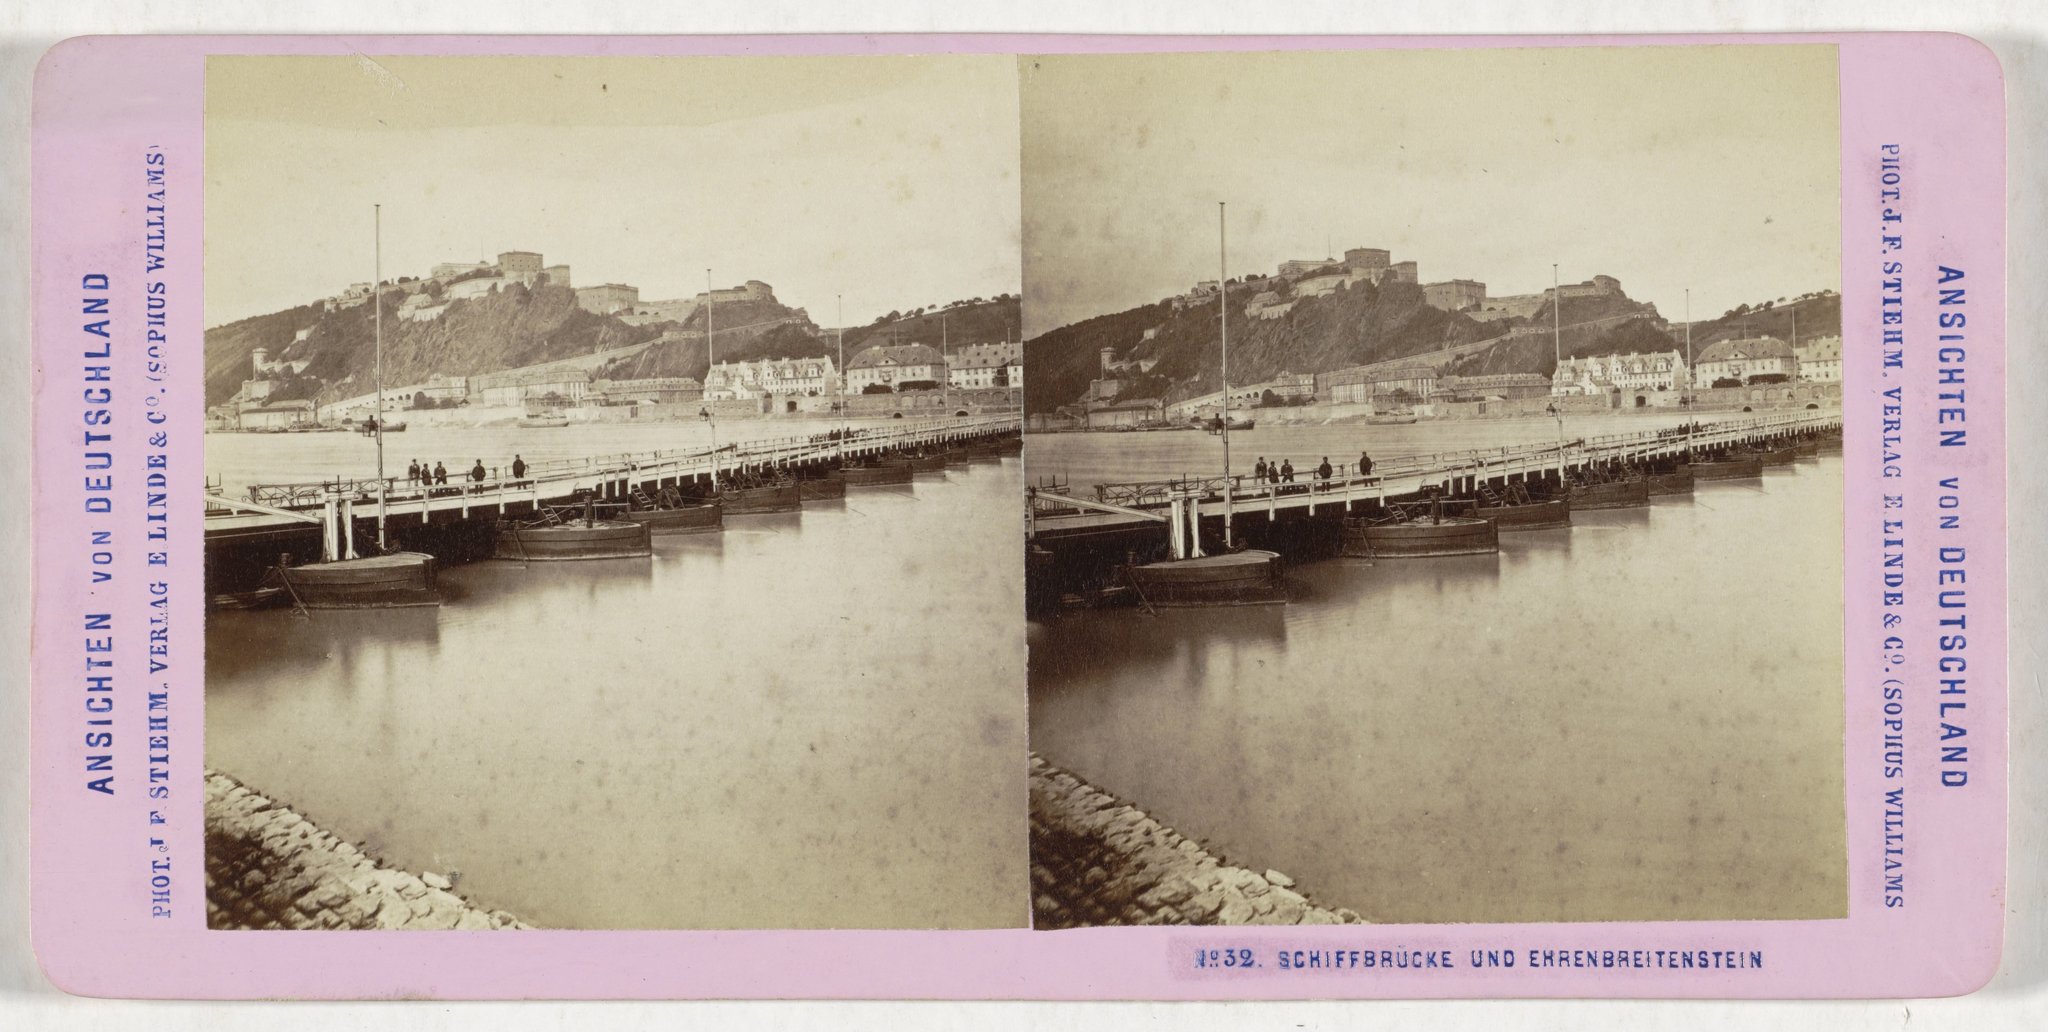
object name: stereograph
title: Schiffbrücke und Ehrenbreitenstein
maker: johann friedrich stiehm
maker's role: fotograaf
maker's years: 1826-1902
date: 1869-1872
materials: cardboard, paper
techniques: albumen print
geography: berlin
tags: castle, river, pontoon bridge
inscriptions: number: ‘No 32.’